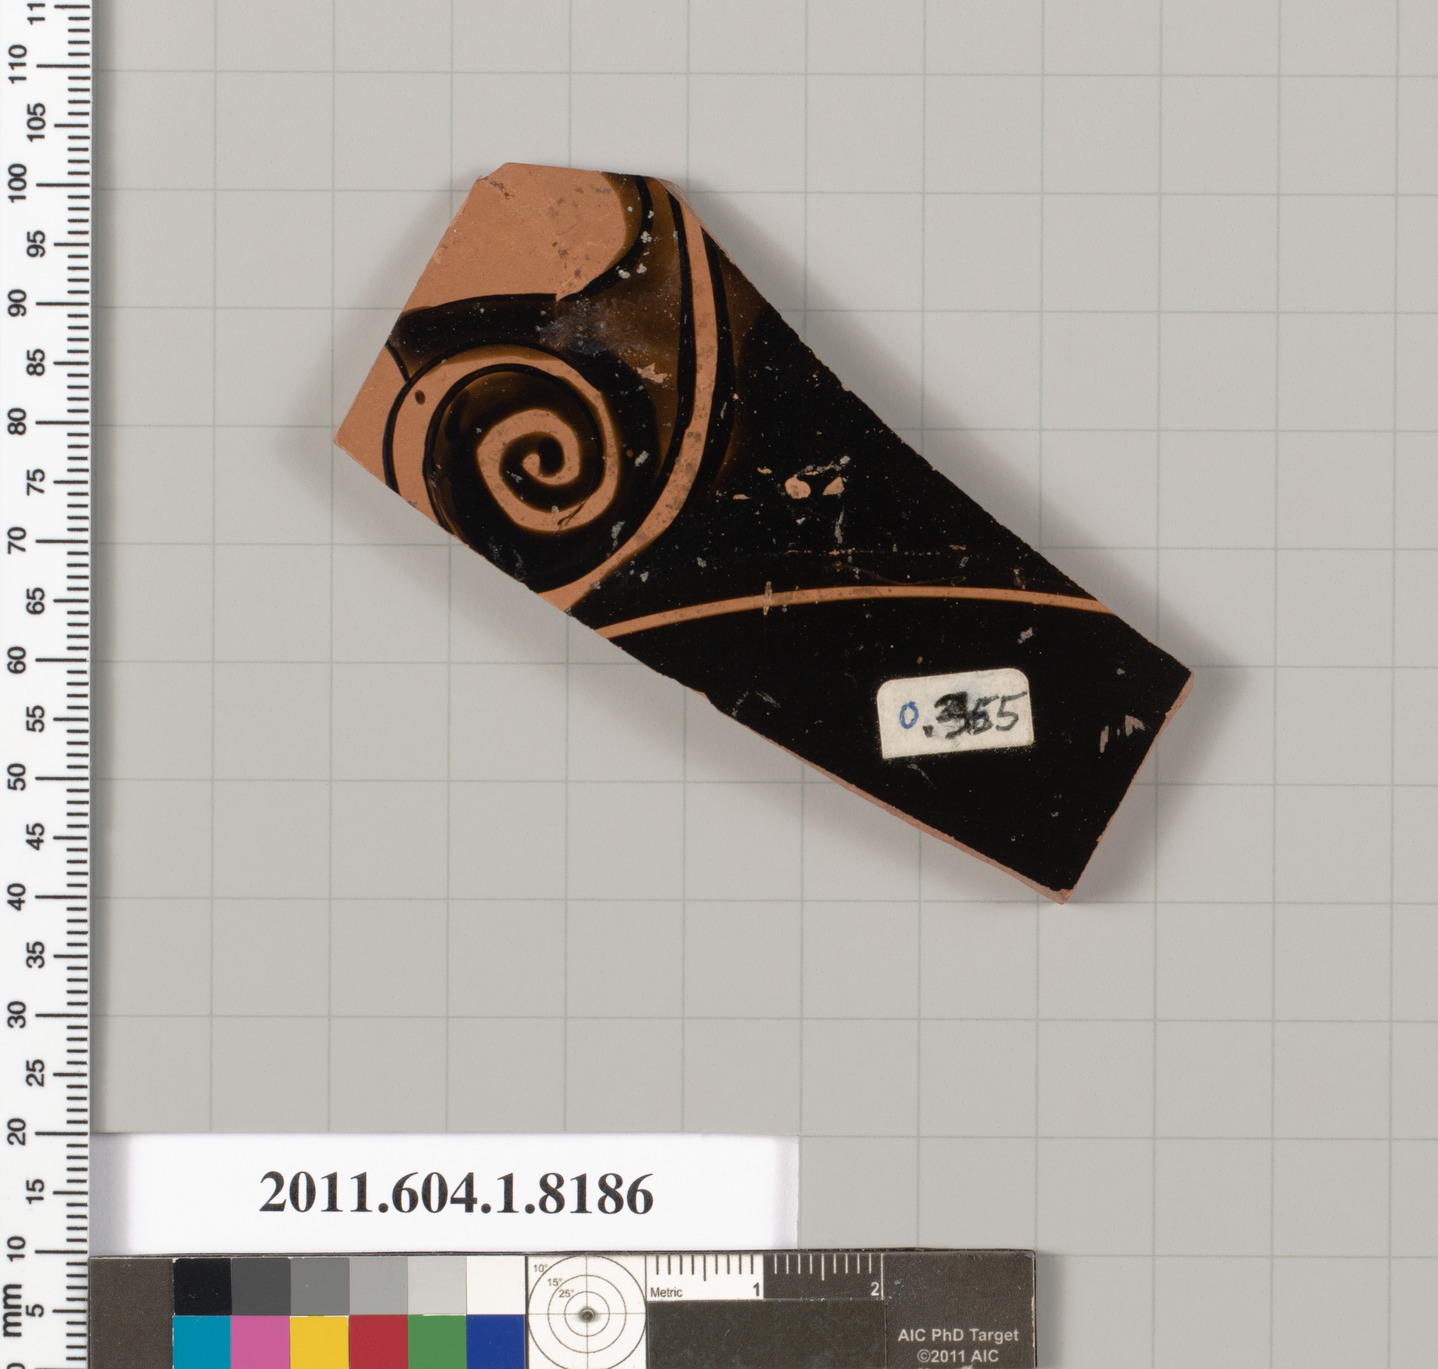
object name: kylix fragment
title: Terracotta fragment of a kylix (drinking cup)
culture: greek, attic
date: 534-501 BCE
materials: terracotta